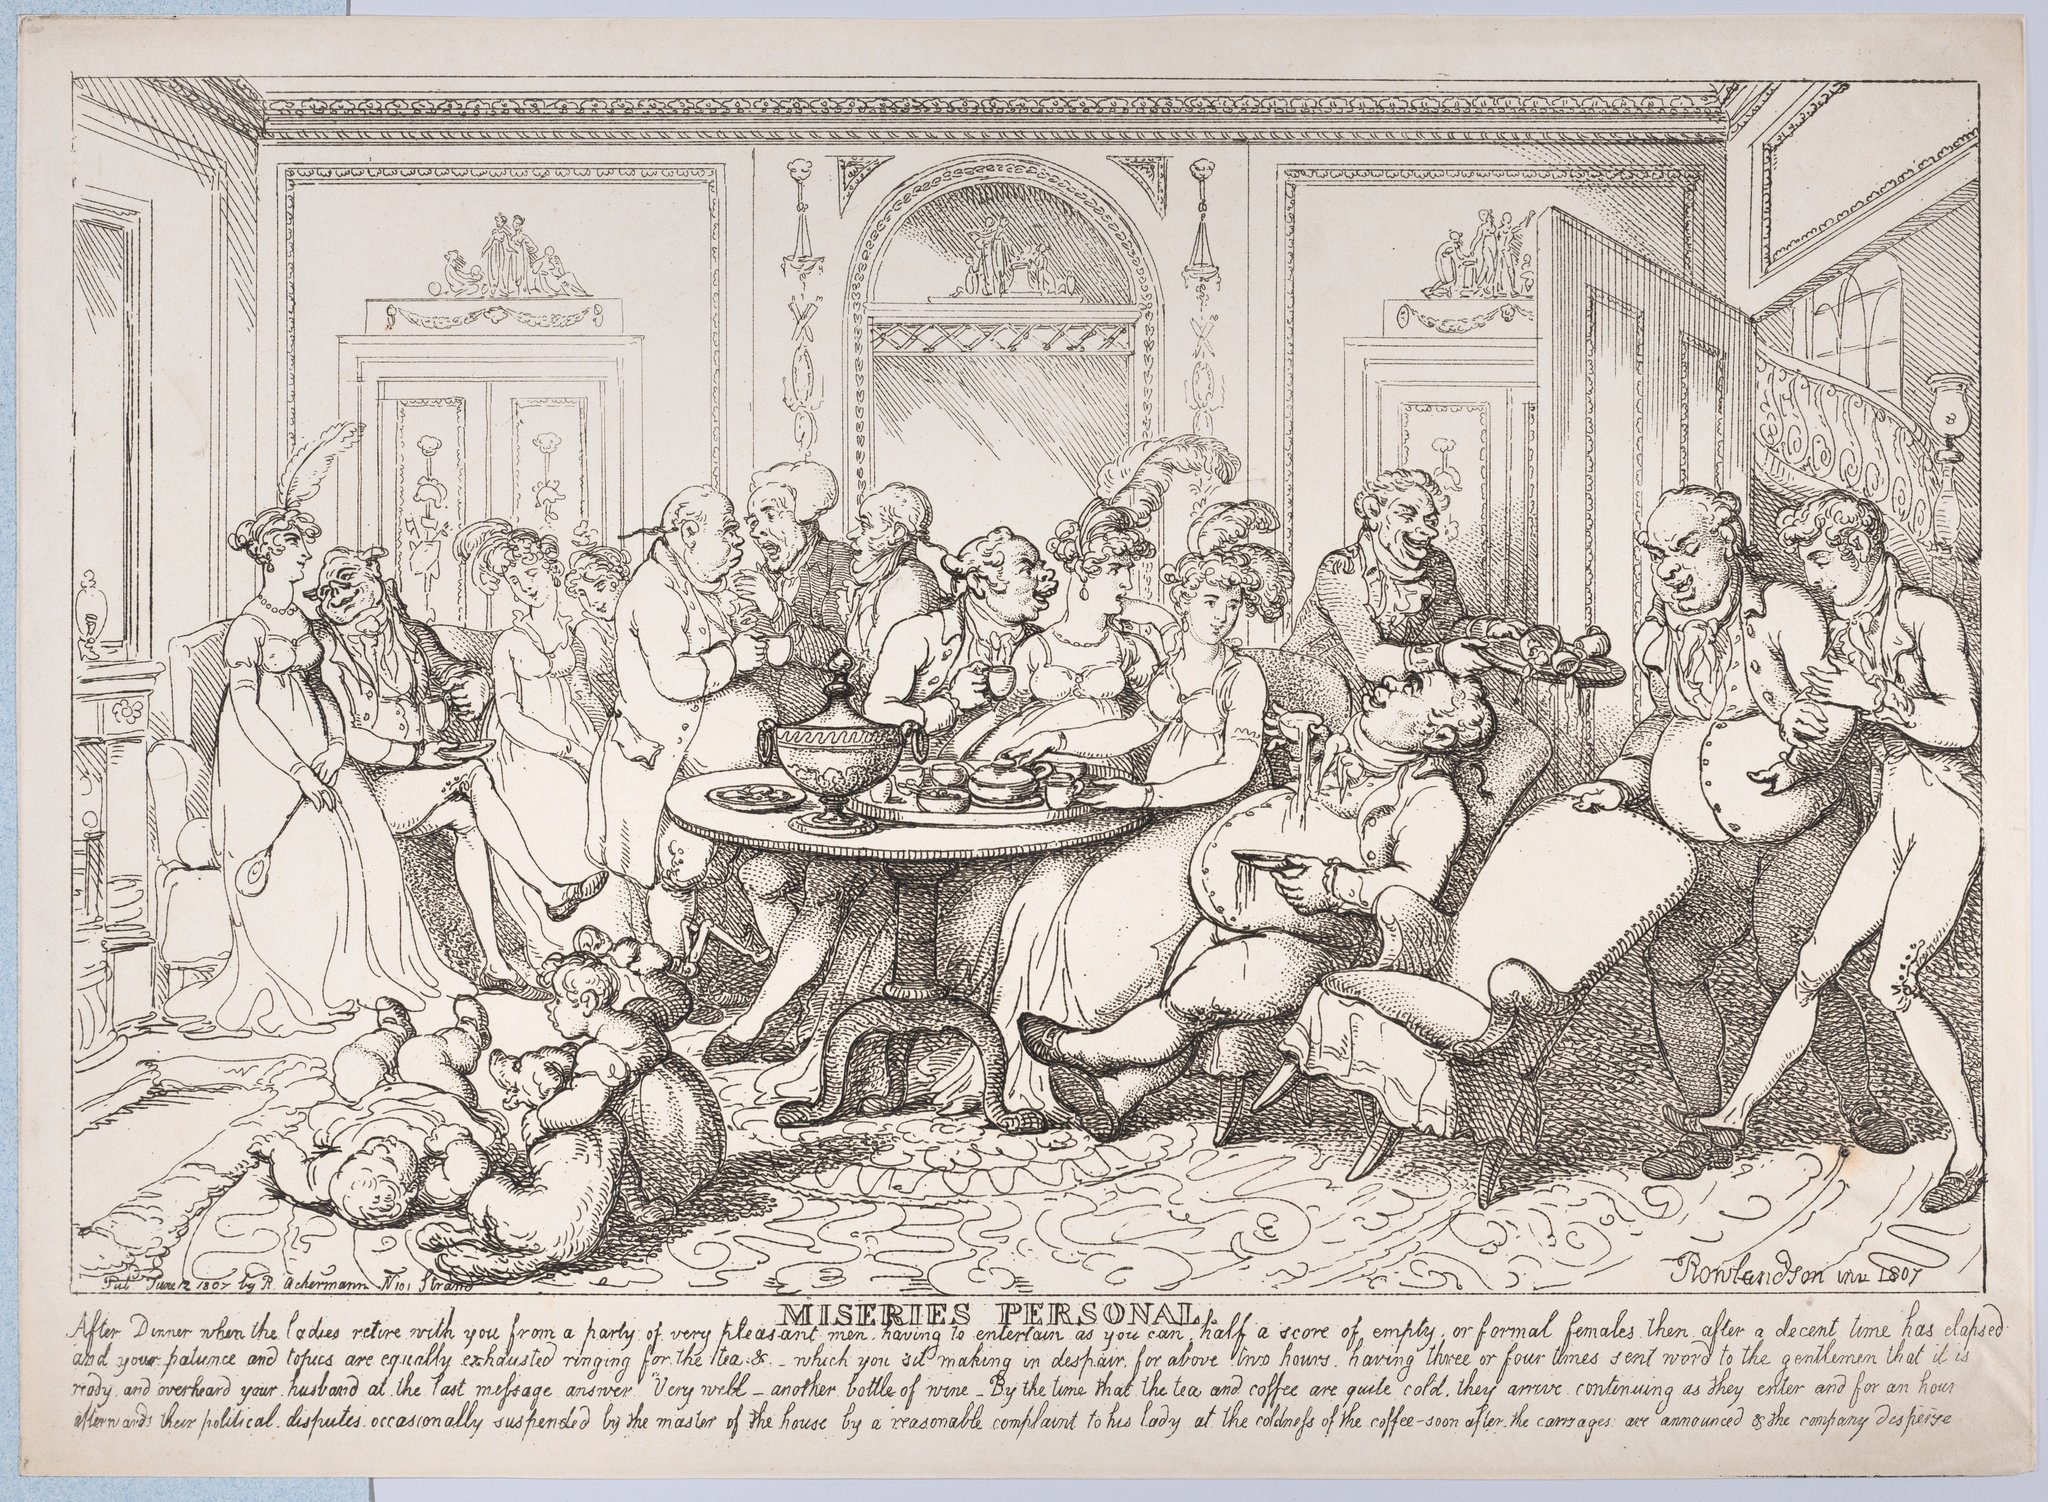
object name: print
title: Miseries Personal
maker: thomas rowlandson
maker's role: artist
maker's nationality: british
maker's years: 1757-1827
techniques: etching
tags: satire,men,women,party,drinking